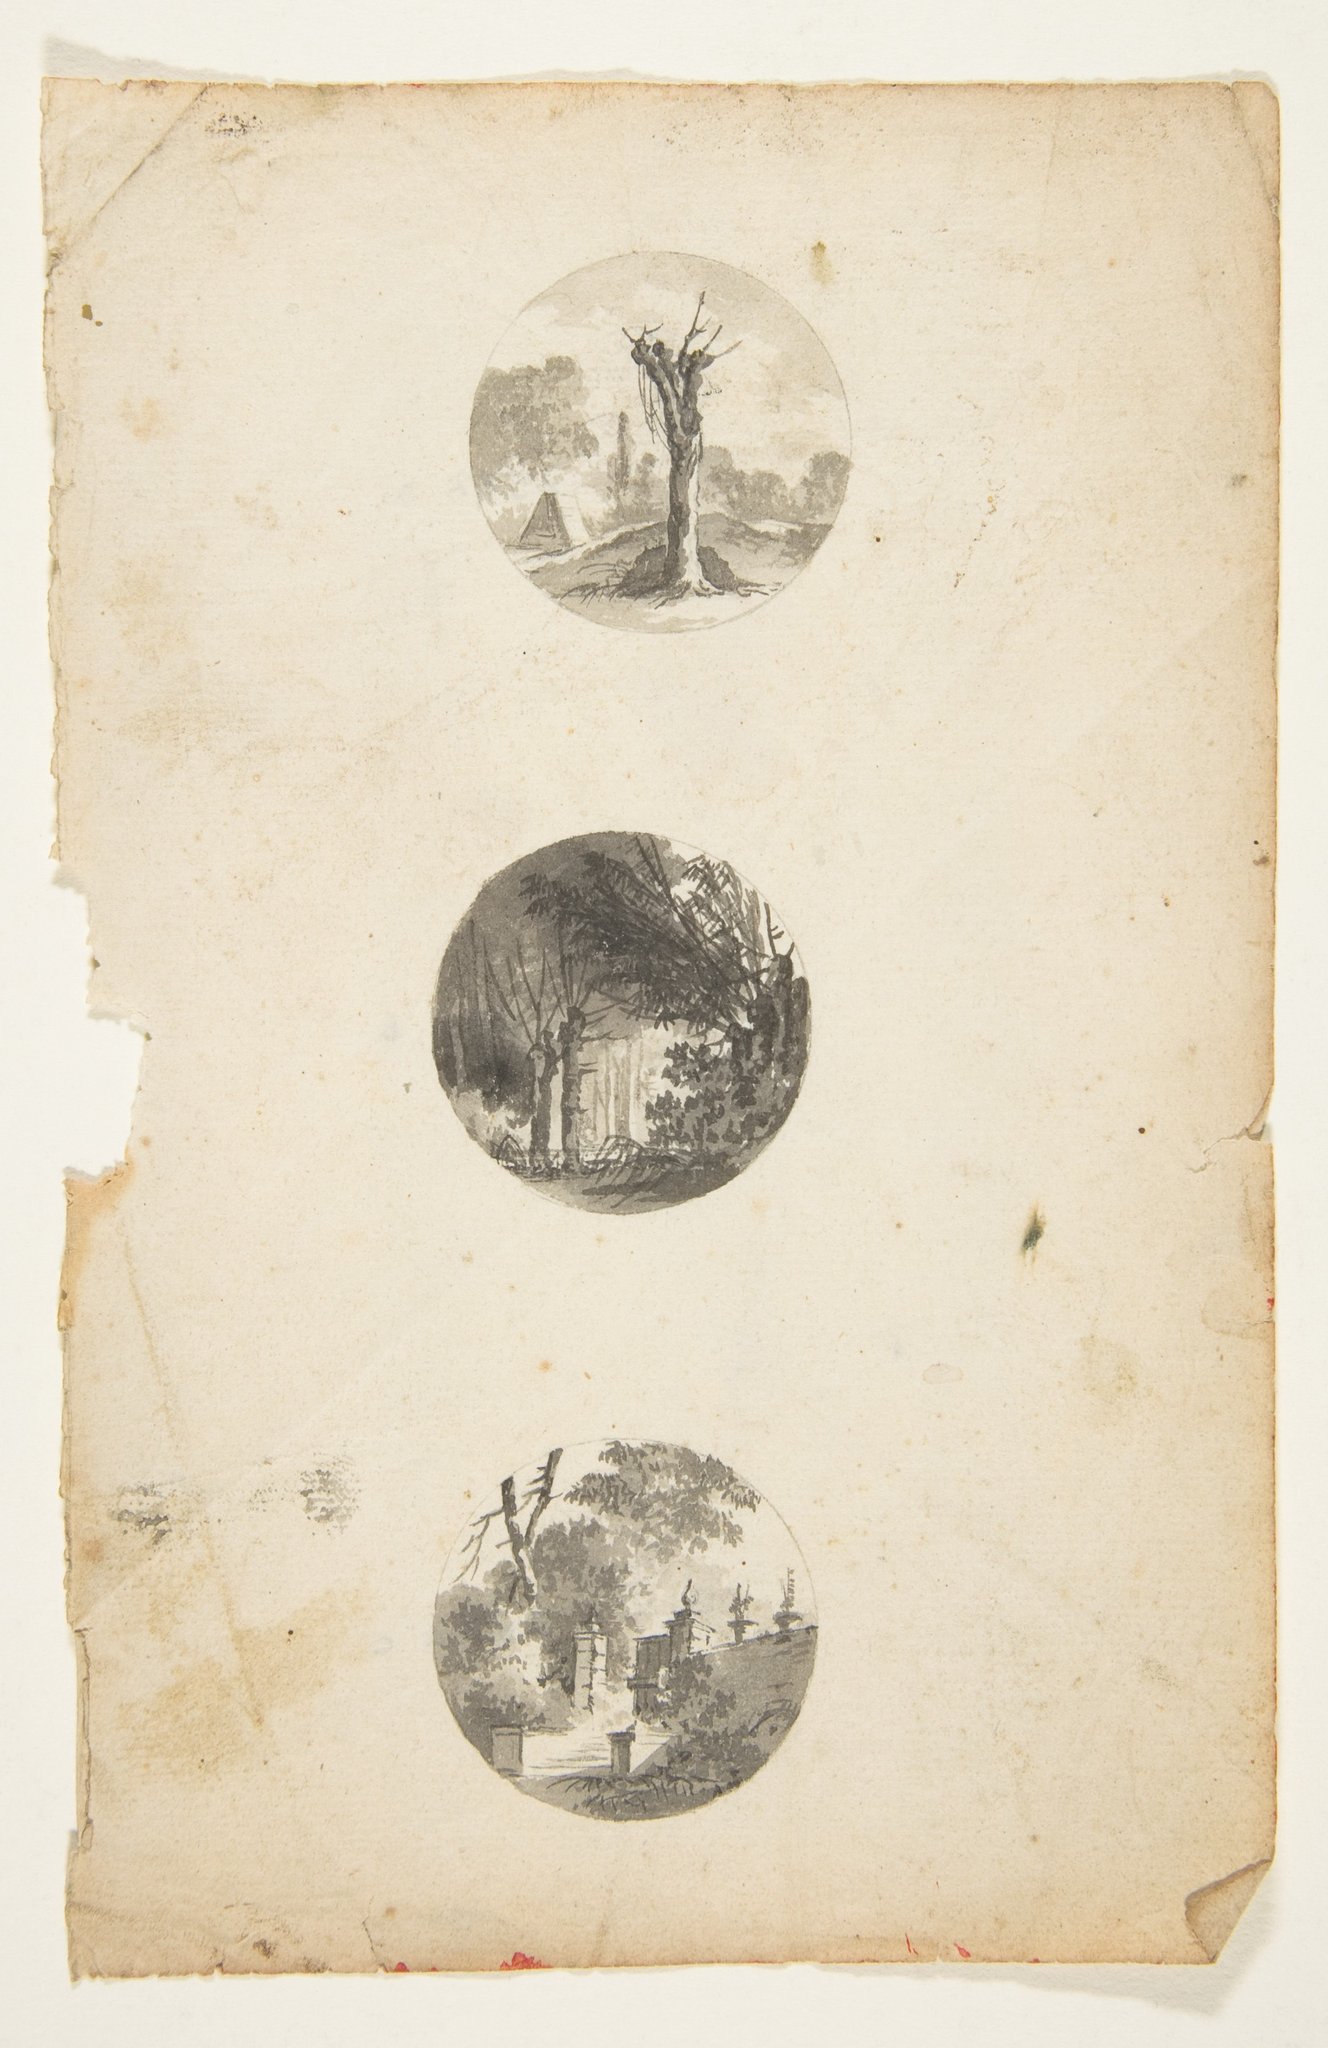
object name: drawing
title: Designs for Buttons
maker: anonymous, french, 18th century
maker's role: artist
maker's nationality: french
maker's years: 1700-1800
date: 1701-1800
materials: paper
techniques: brush, wash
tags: trees